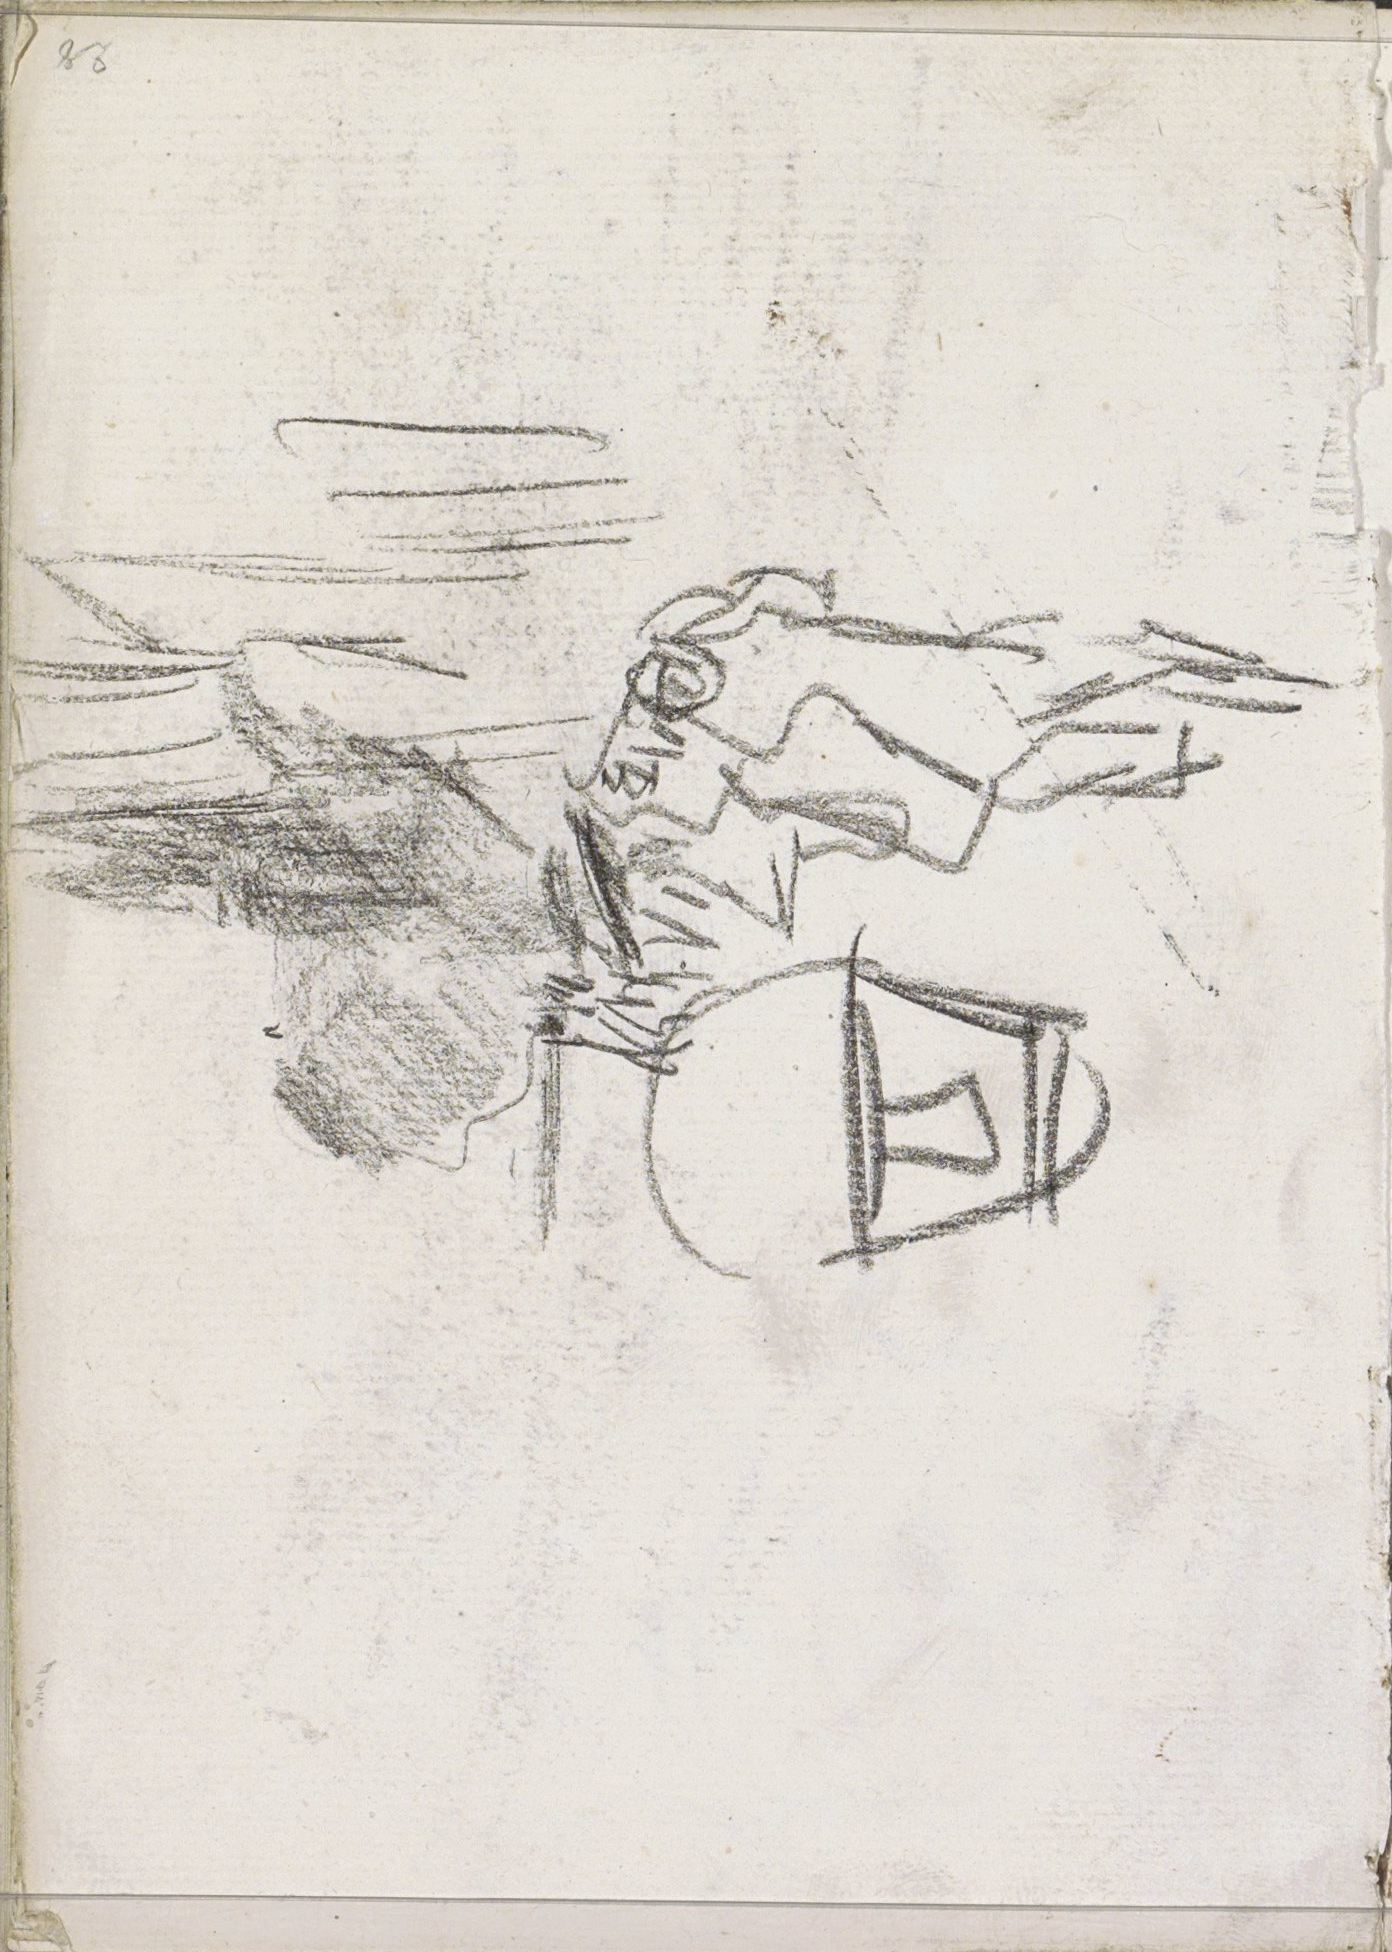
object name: sketchbook leaf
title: Figuren op straat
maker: isaac israels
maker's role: draughtsman, painter, print maker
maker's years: 1865-1934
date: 1886-1934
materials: chalk, paper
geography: amsterdam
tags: street (+ city(-scape) with figures, staffage)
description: Blad 15 verso uit schetsboek LV met 21 bladen.